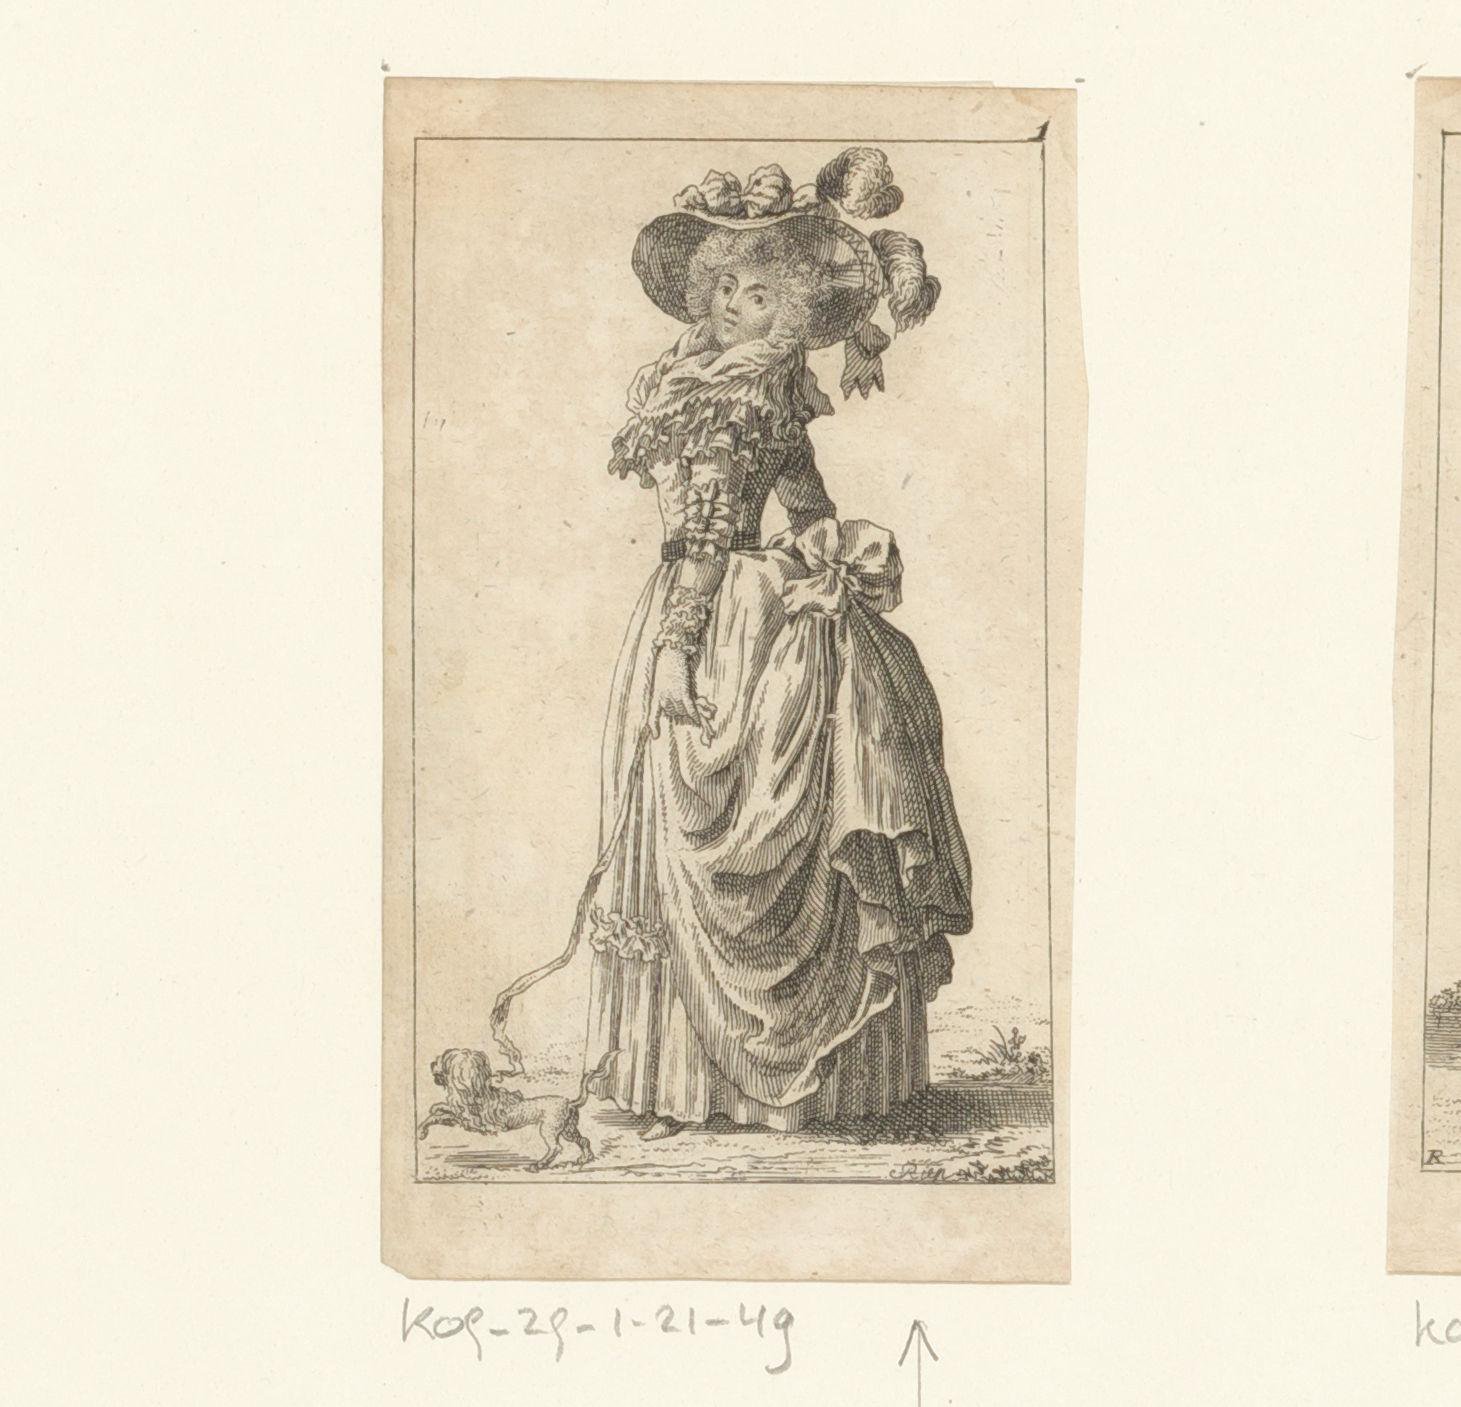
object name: print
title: Staande dame in jurk met een hond aan de lijn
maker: j. rasko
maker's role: draughtsman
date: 1780-1840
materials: paper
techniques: etching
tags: dress, gown, clothes, costume, dog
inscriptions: stamp, collector's mark: Lugt 1641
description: Rechtsboven genummerd: 1. Onderwerpsrubrieken binnen de Atlas Zeden en Gewoonten: Zeden en Gewoonten in Engeren Zin, De Kleeding, Kleederdrachten (tijdvakken), De 18de eeuw (de pruikentijd). Mannen en vrouwen.